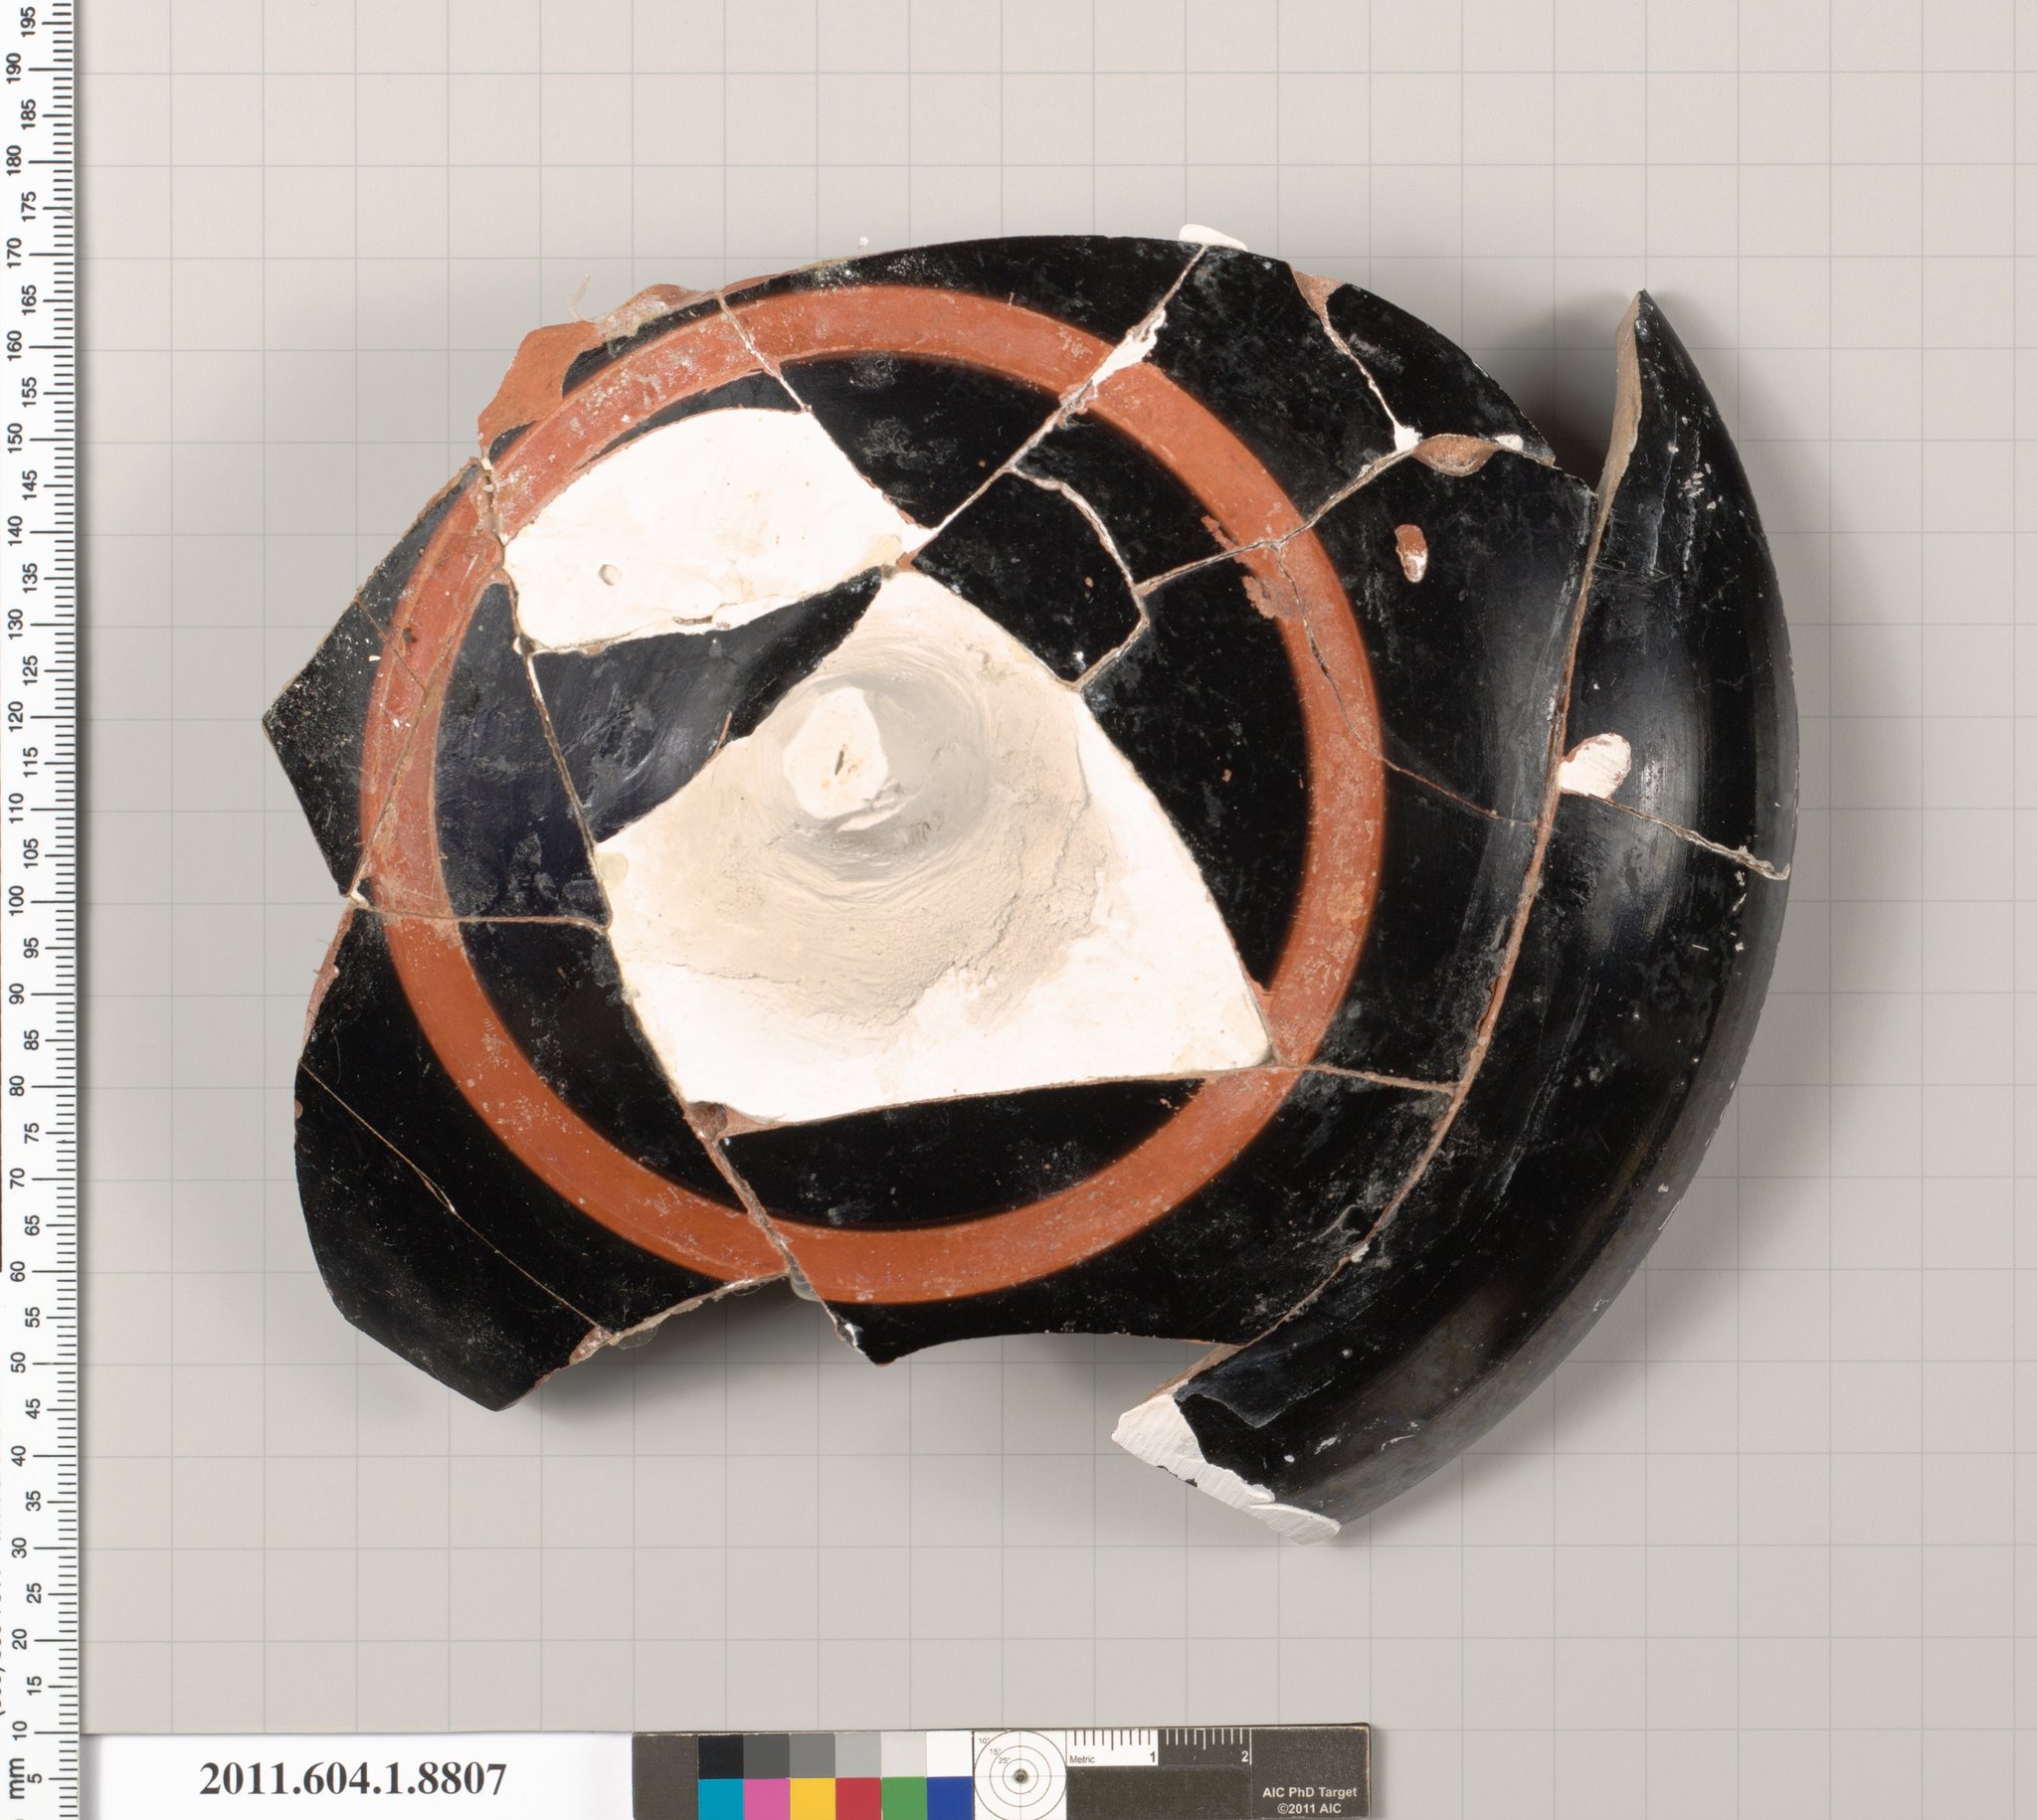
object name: kylix or foot bowl fragment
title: Terracotta fragment of a kylix (drinking cup) or a footed bowl?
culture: greek, attic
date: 490-480 BCE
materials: terracotta